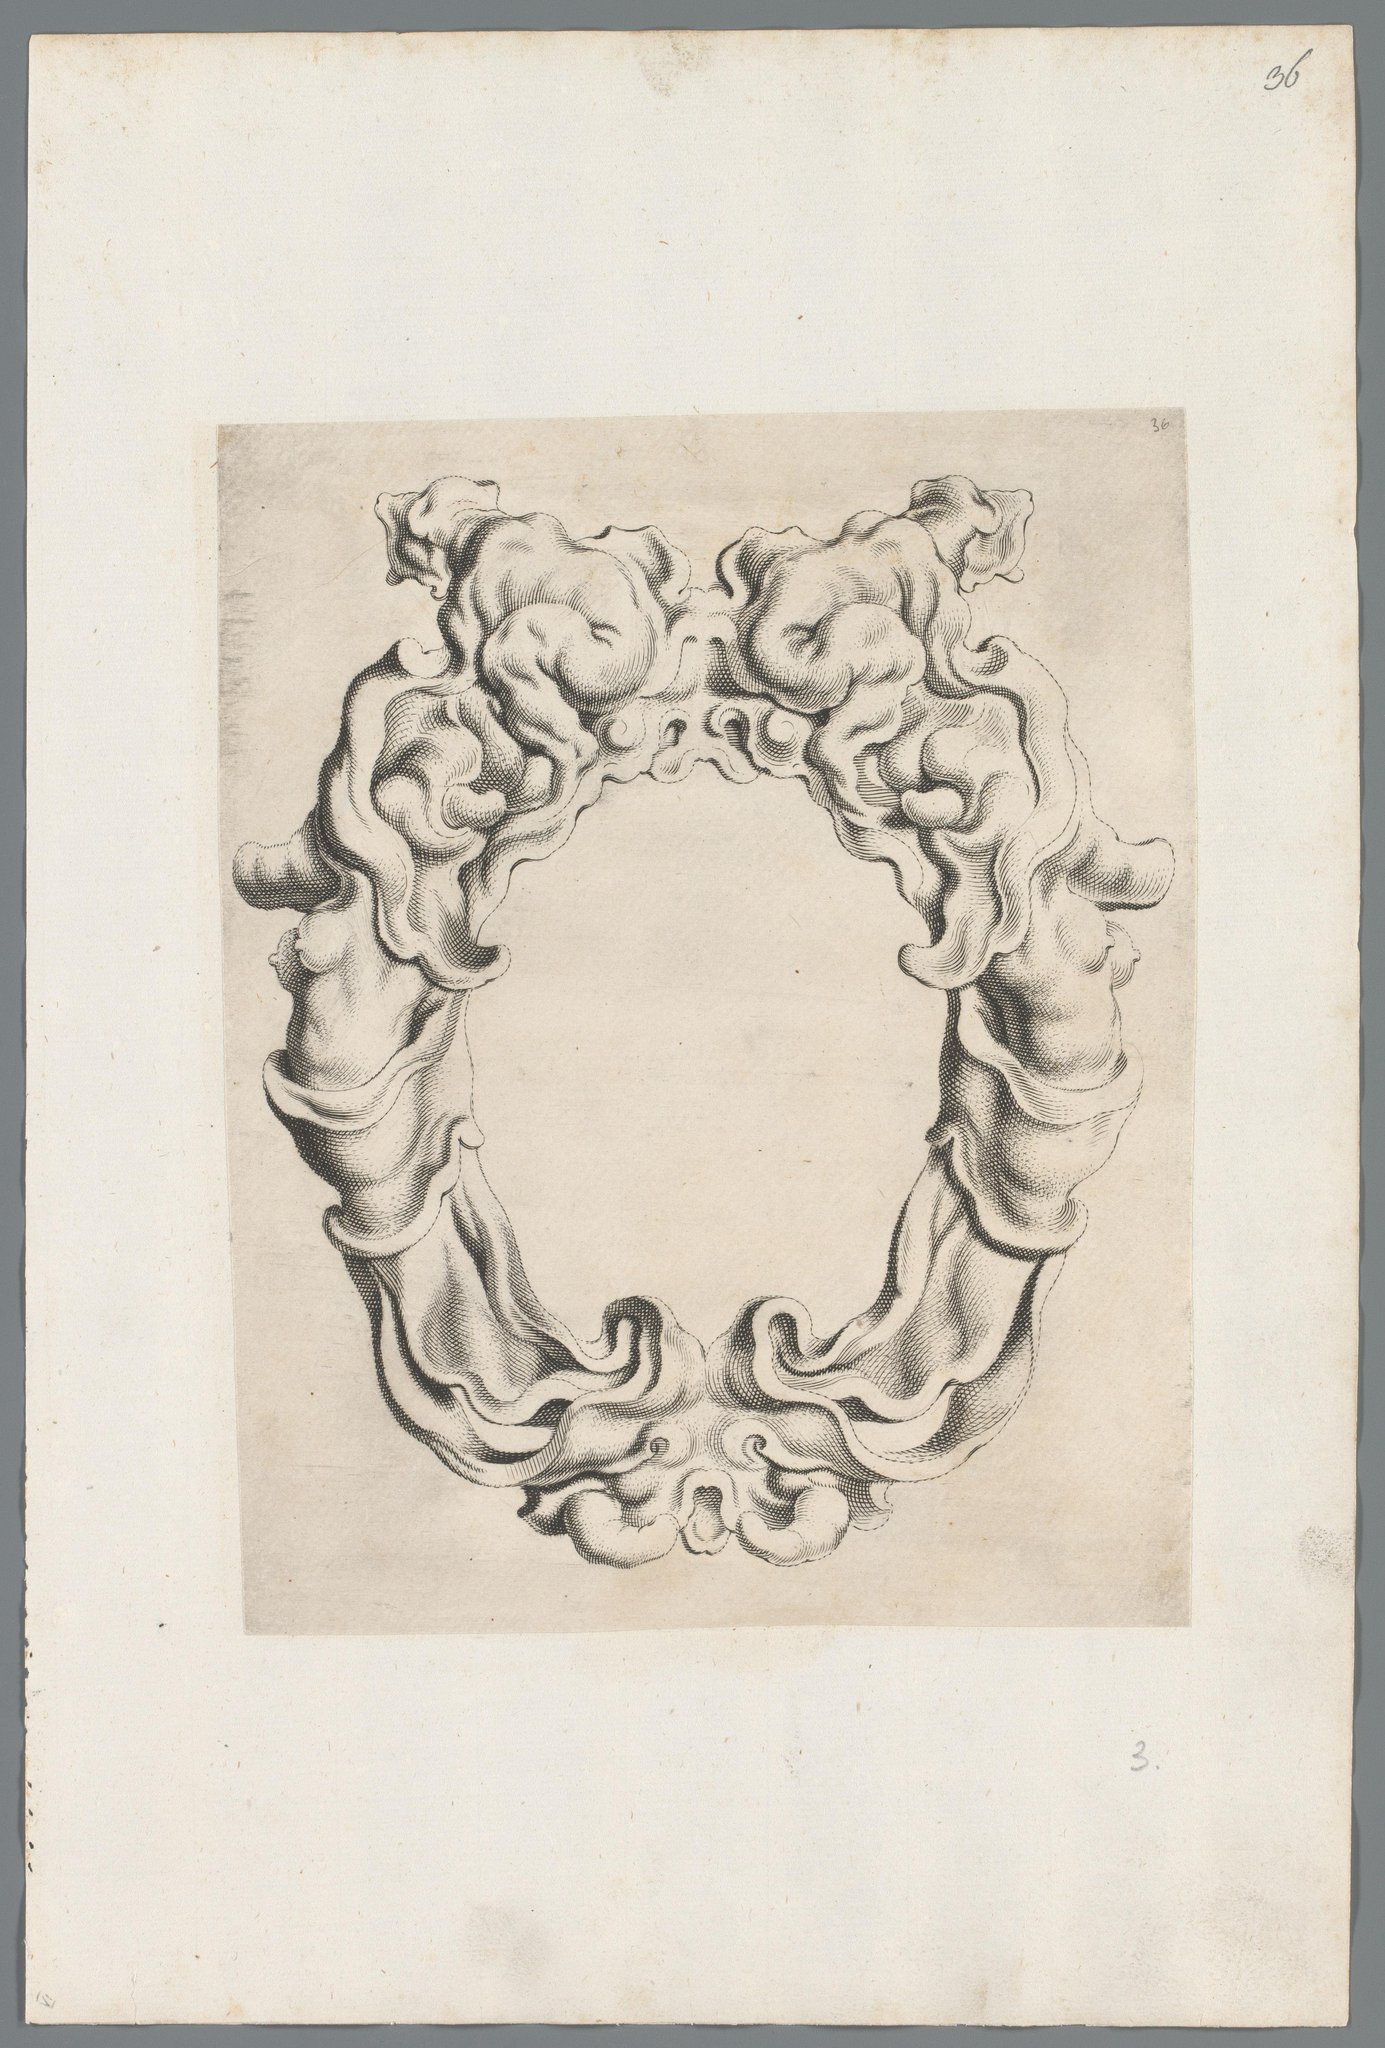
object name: print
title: Cartouche in kwabstijl met vrouwentorso en hond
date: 1640-1674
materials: paper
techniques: engraving, etching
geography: amsterdam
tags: auricular ornament, lobe style ~ ornament, ornament ~ cartouche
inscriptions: collector's mark: Lugt 2760, collector's mark: Lugt 2228